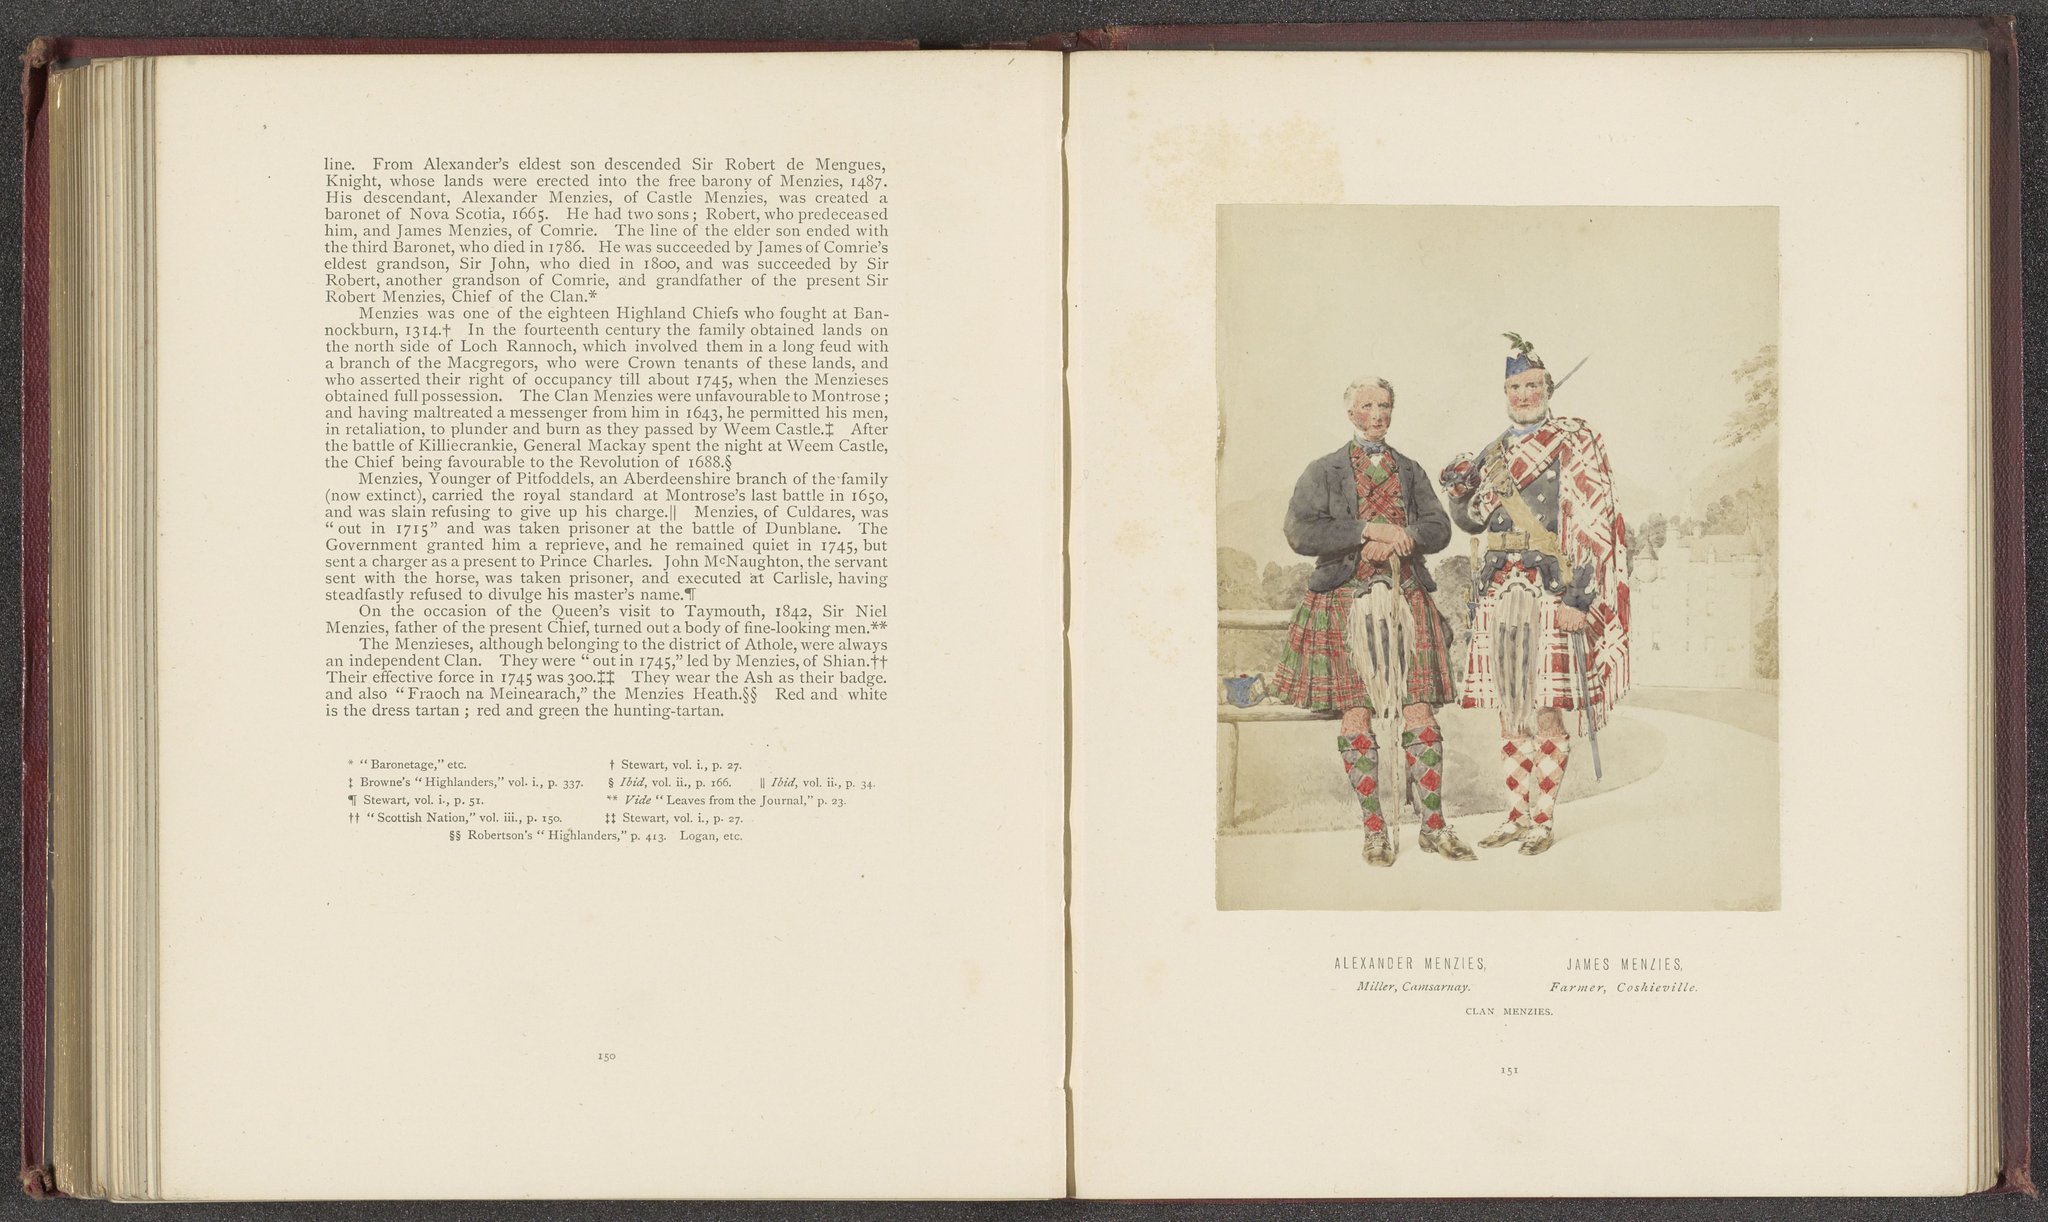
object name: photograph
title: Alexander Menzies, Miller, Camsarnay. James Menzies, Farmer, Coshieville. Clan Menzies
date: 1860-1870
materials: photographic support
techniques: albumen print, hand coloring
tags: adult man, folk costume, regional costume